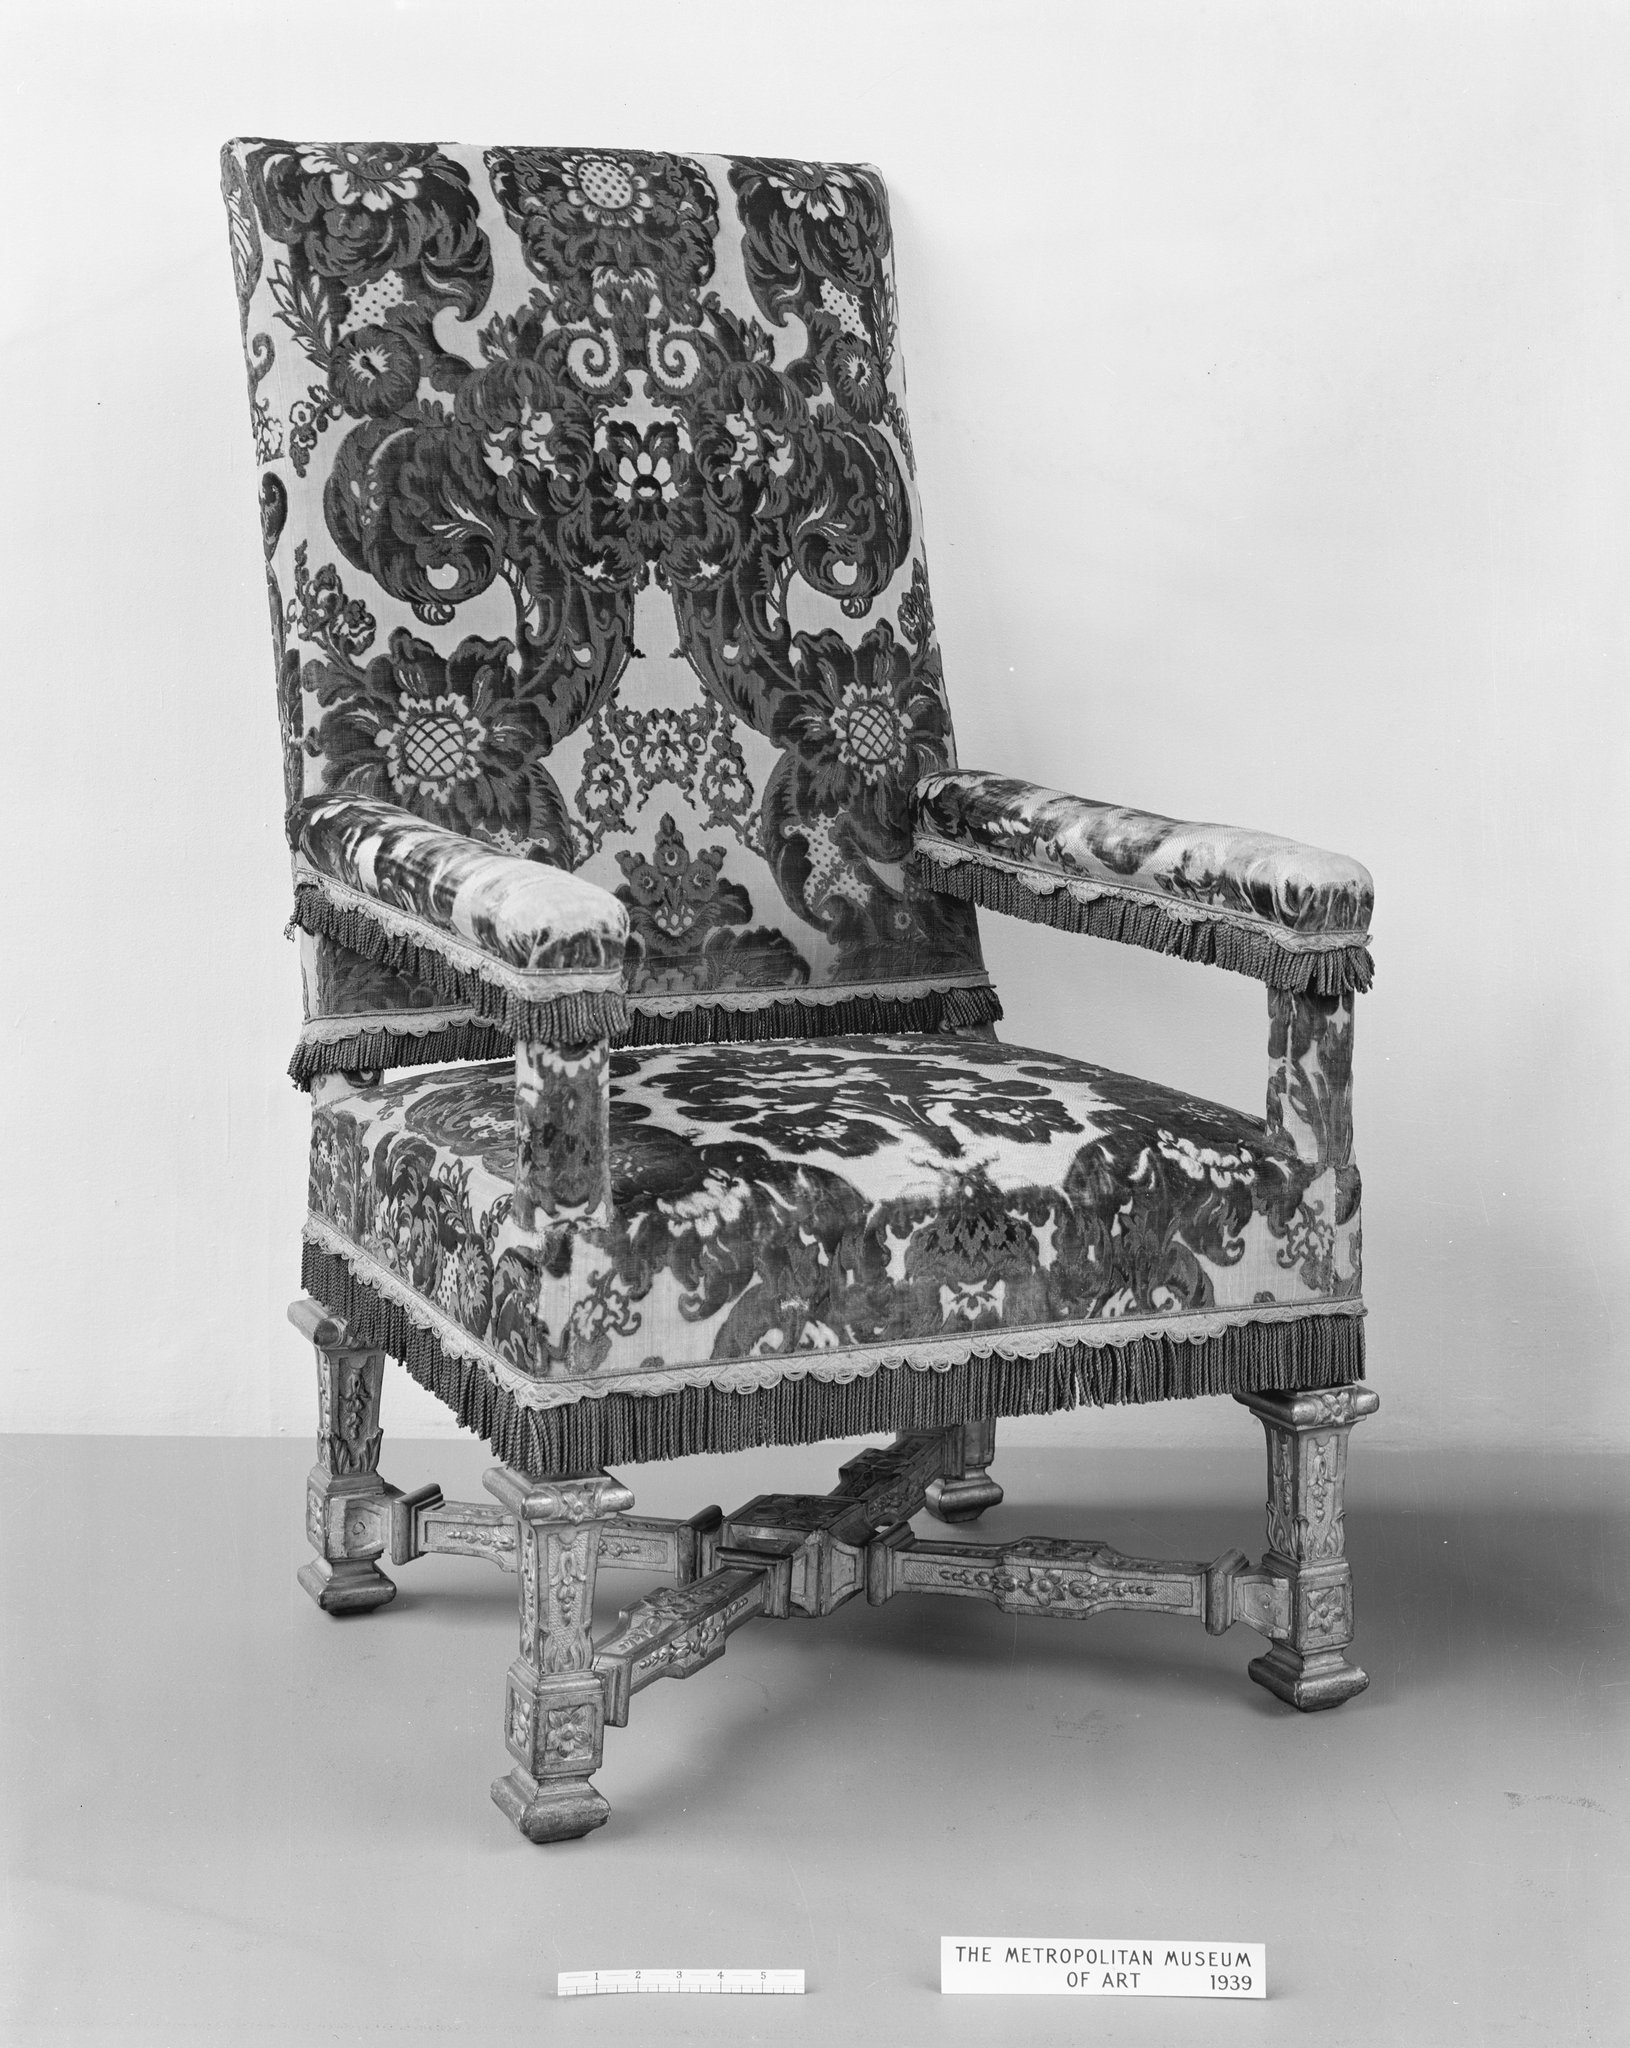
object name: armchair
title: Armchair (one of a pair)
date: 1676-1700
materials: wood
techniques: carving, gilding